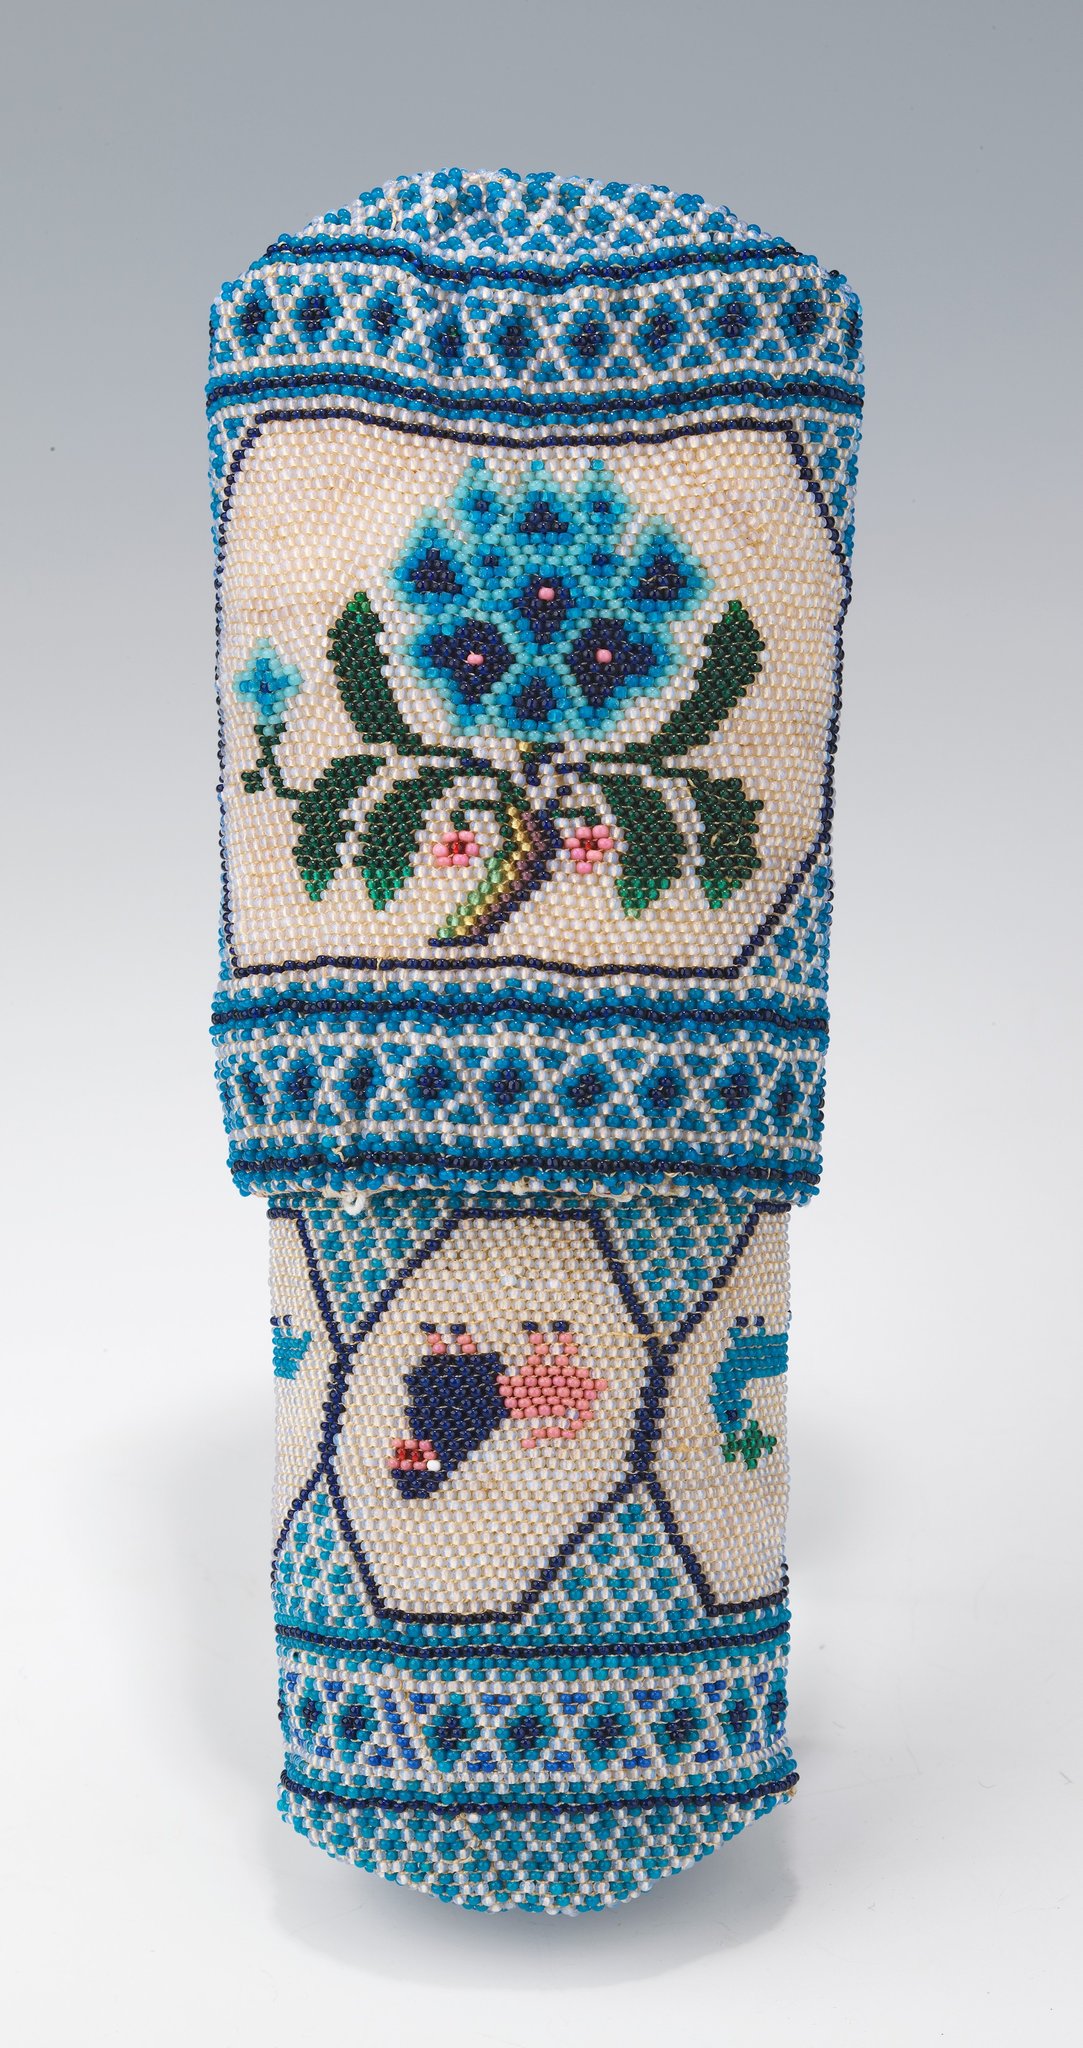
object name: purse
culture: mexican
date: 1867-1900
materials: glass, silk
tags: flowers